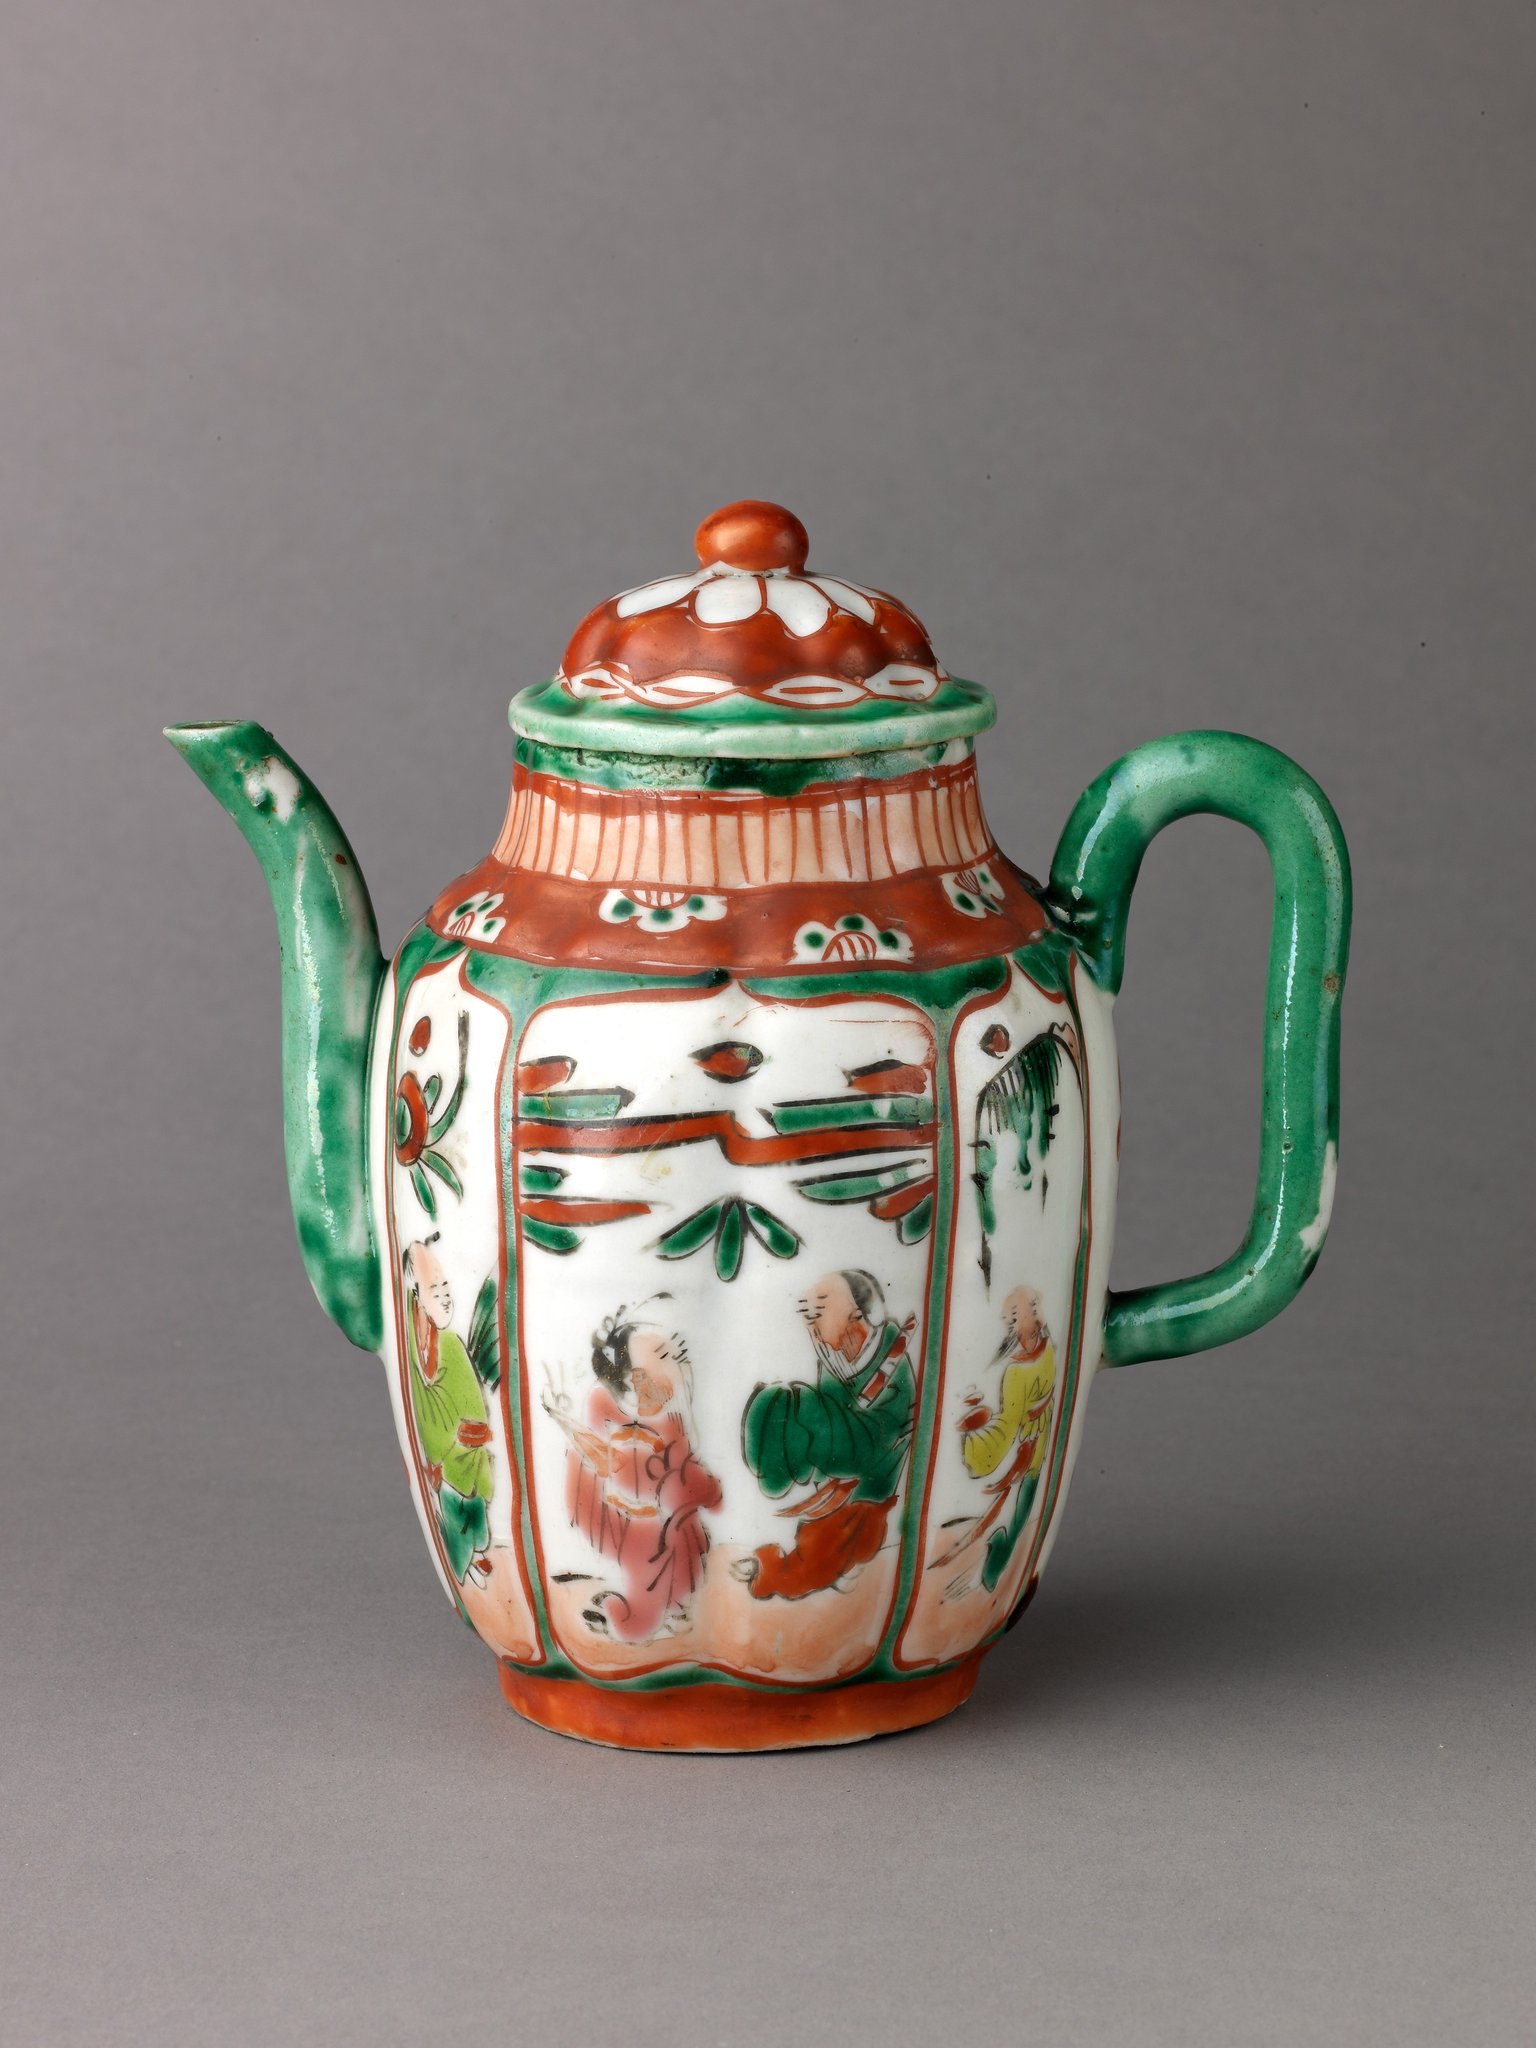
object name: covered ewer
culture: chinese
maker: chinese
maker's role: artist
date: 1801-1900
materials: enamel, porcelain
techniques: overglaze, painting, polychrome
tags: men